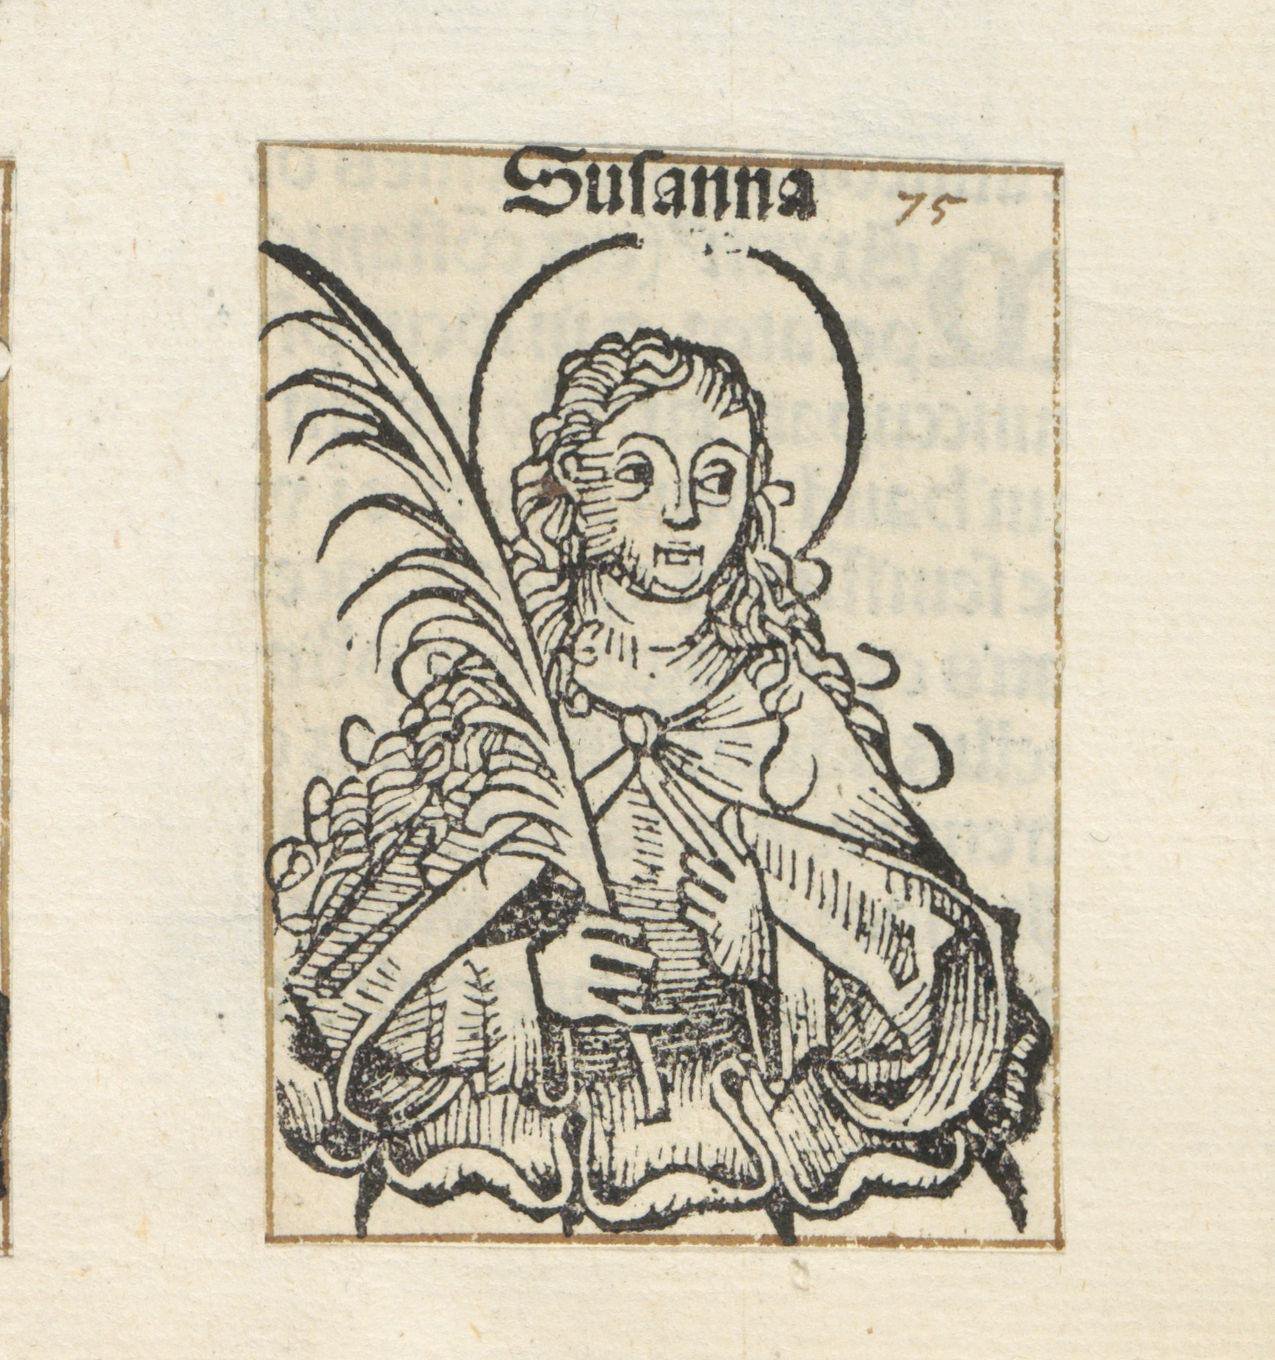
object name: album leaf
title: Heilige Susanne van Rome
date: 1493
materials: paper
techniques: letterpress printing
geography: nuremberg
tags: martyr(s) (often with palm-branches), female saints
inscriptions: inscription: ‘75’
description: De houtsnede wordt herhaaldelijk gebruikt als boekillustratie in de Liber Chronicarum (of Neurenbergkroniek) van Hartmann Schedel, verschenen in het Latijn en Duits in 1493. Zie de Latijnse uitgave, folio 127v.